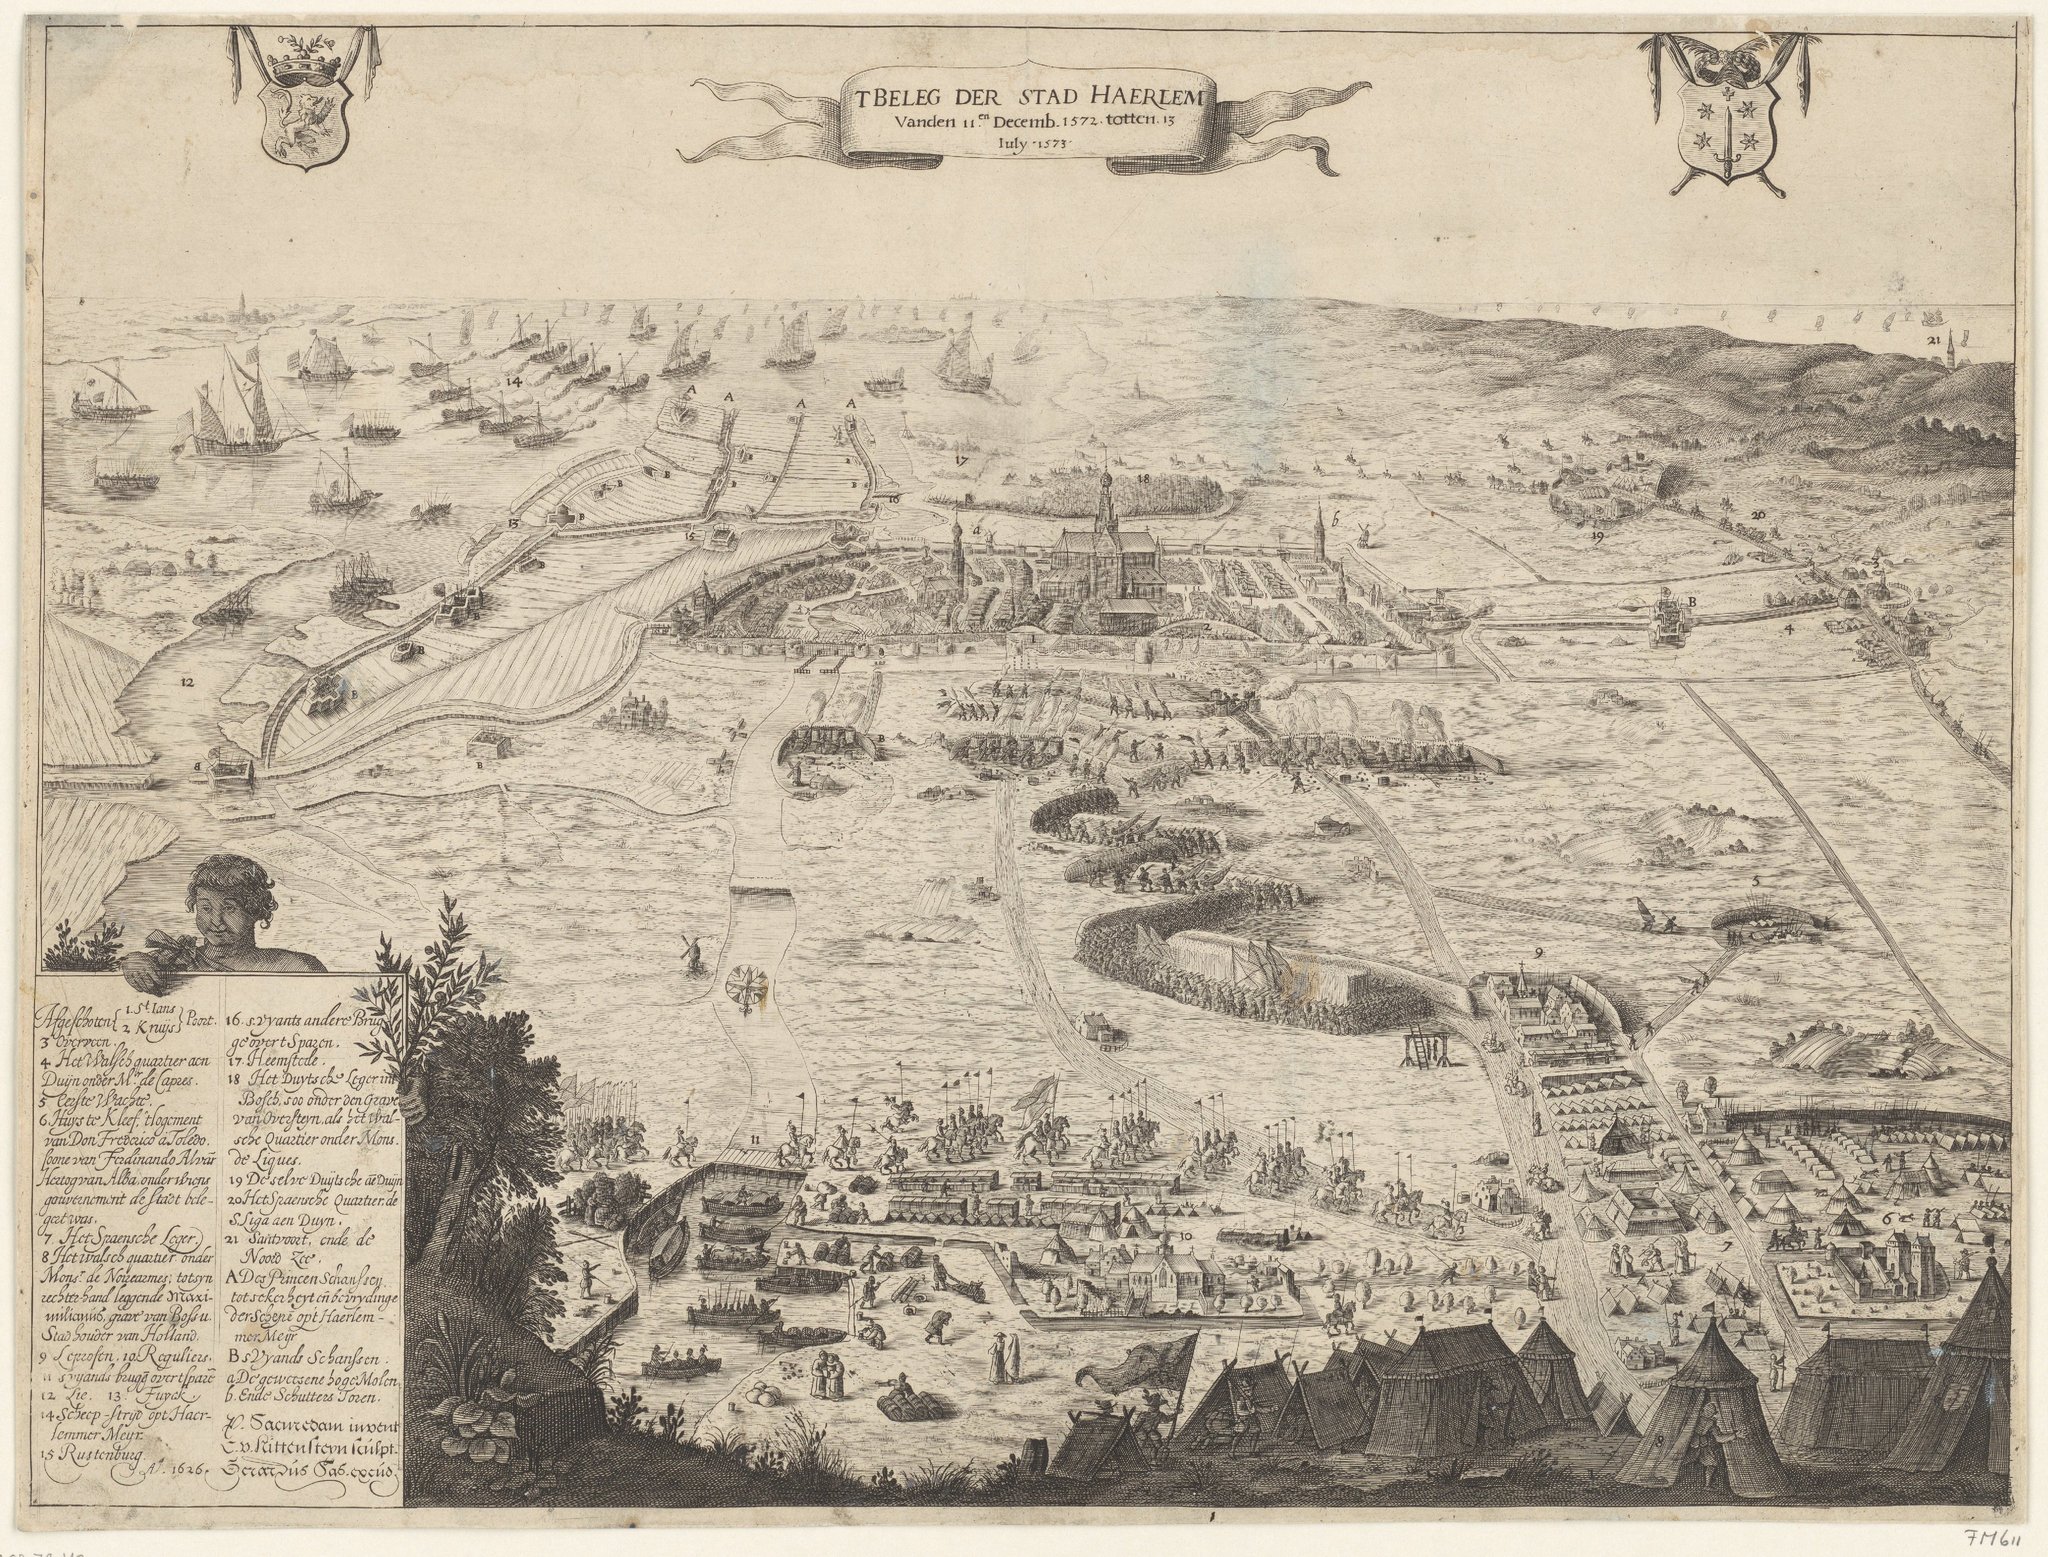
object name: print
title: Beleg van Haarlem, 1572-1573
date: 1626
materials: paper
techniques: engraving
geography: northern netherlands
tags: siege, position war, haarlem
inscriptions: date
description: Overzicht van het beleg van de stad Haarlem met het omringend gebied. Op de voorgrond de legerplaats van de Spaanse troepen bij het Huis ter Kleef. Linksonder een cartouche opgehouden door een jonge man met de legenda 1-21 en A-B in het Nederlands.